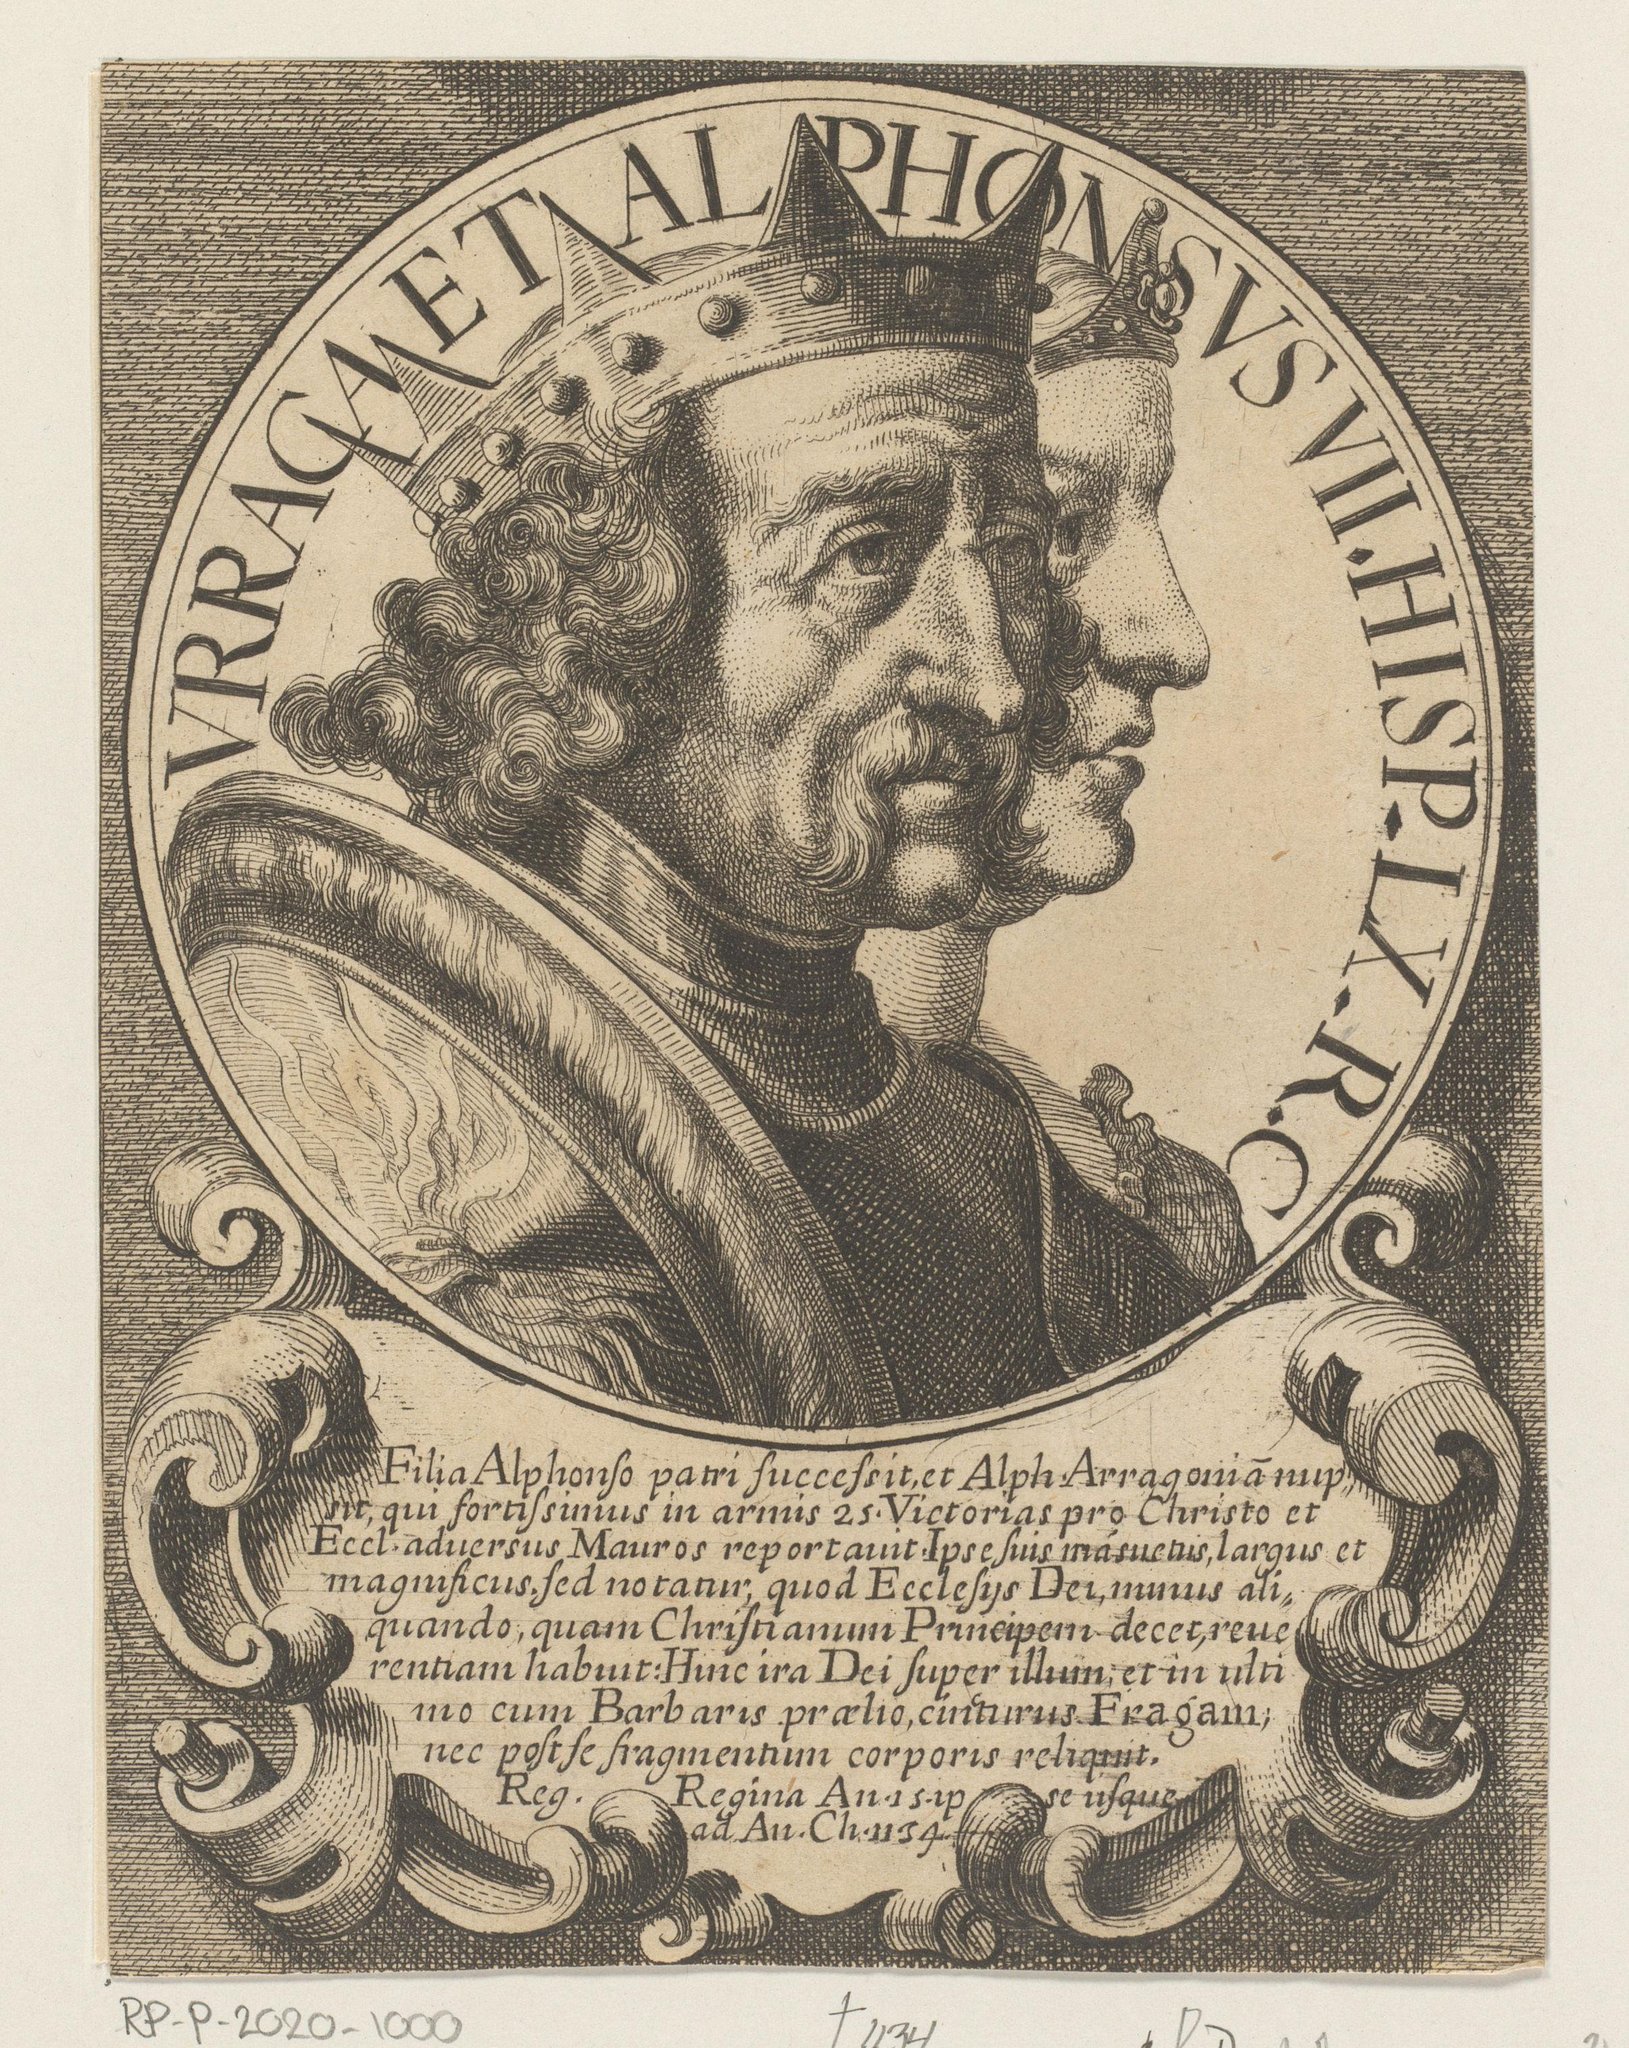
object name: print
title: Urraca et Alphonsus VII Hisp LX R C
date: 1684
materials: paper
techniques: engraving, etching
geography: rome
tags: historical persons - bb - woman, historical persons, queen, ruler, sovereign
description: Portret mogelijk afkomstig van een grote prent, getiteld 'Effigies et series regum Hispaniae primum ex Gothis Christianorum (...)', bestaande uit meerdere bladen die samengevoegd konden worden, uitgegeven door Giovanni Giacomo de' Rossi in 1684.